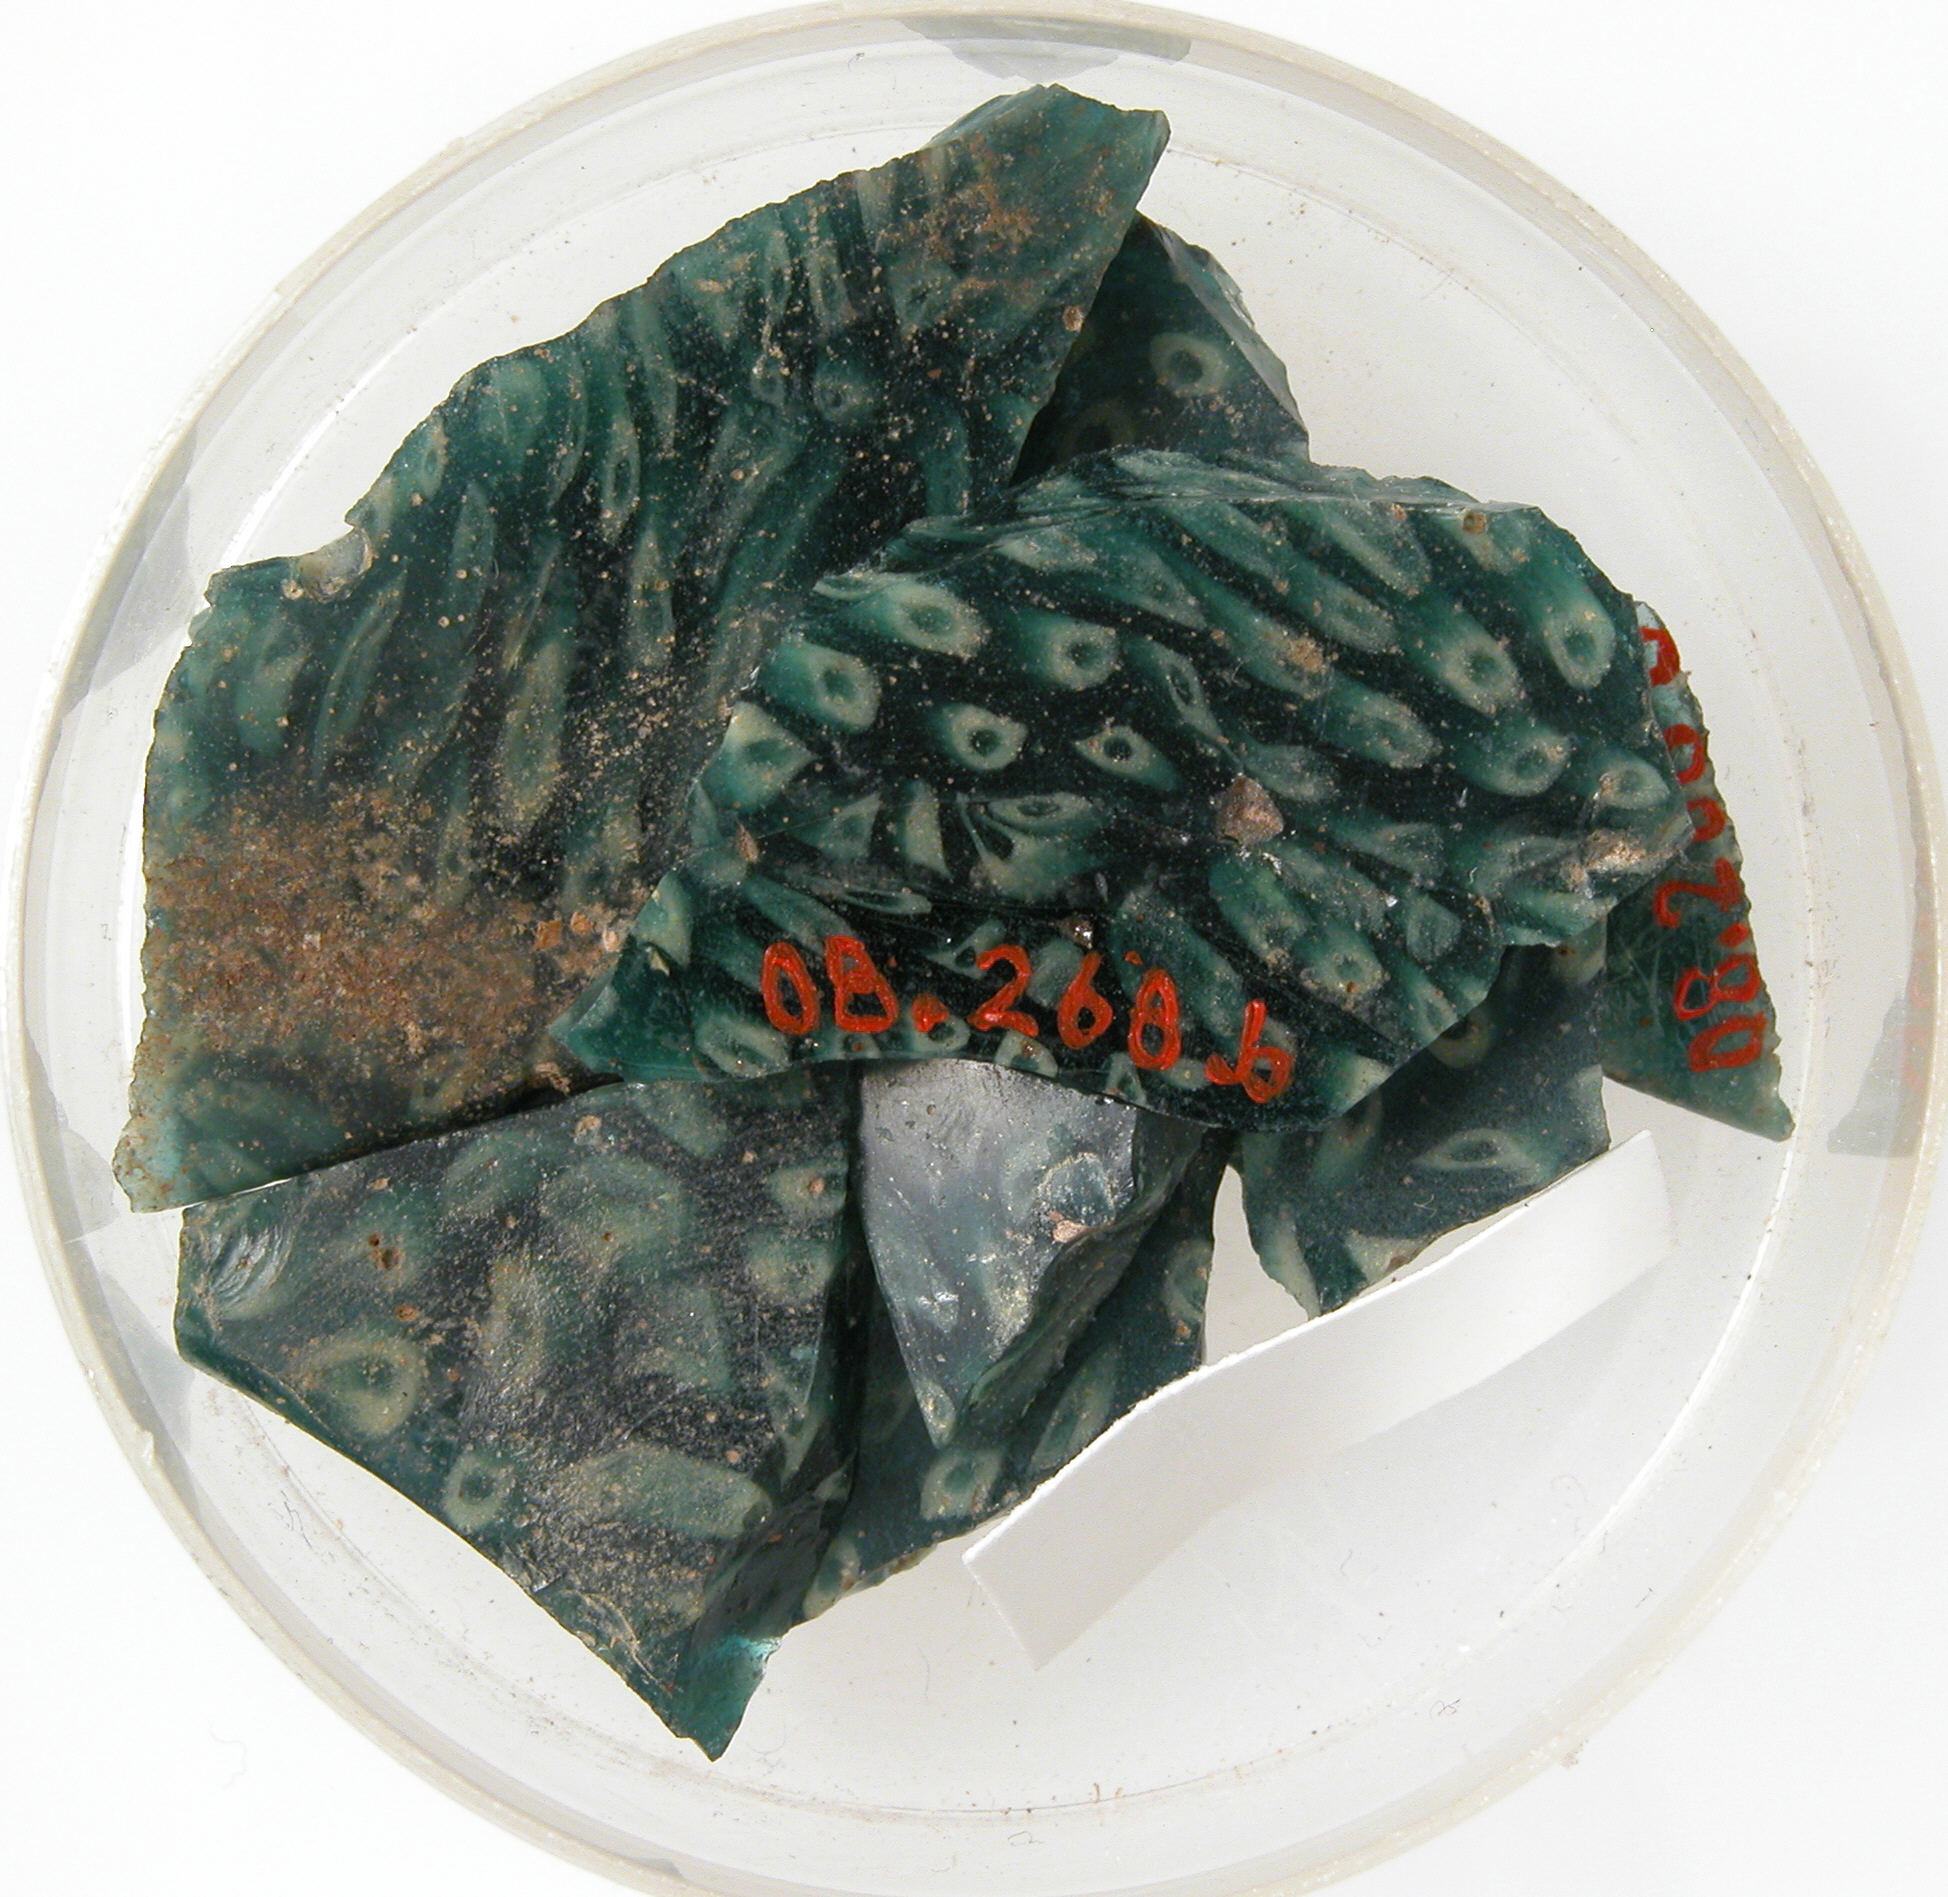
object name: fragment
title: Glass Fragments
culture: coptic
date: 301-433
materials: glass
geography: egypt